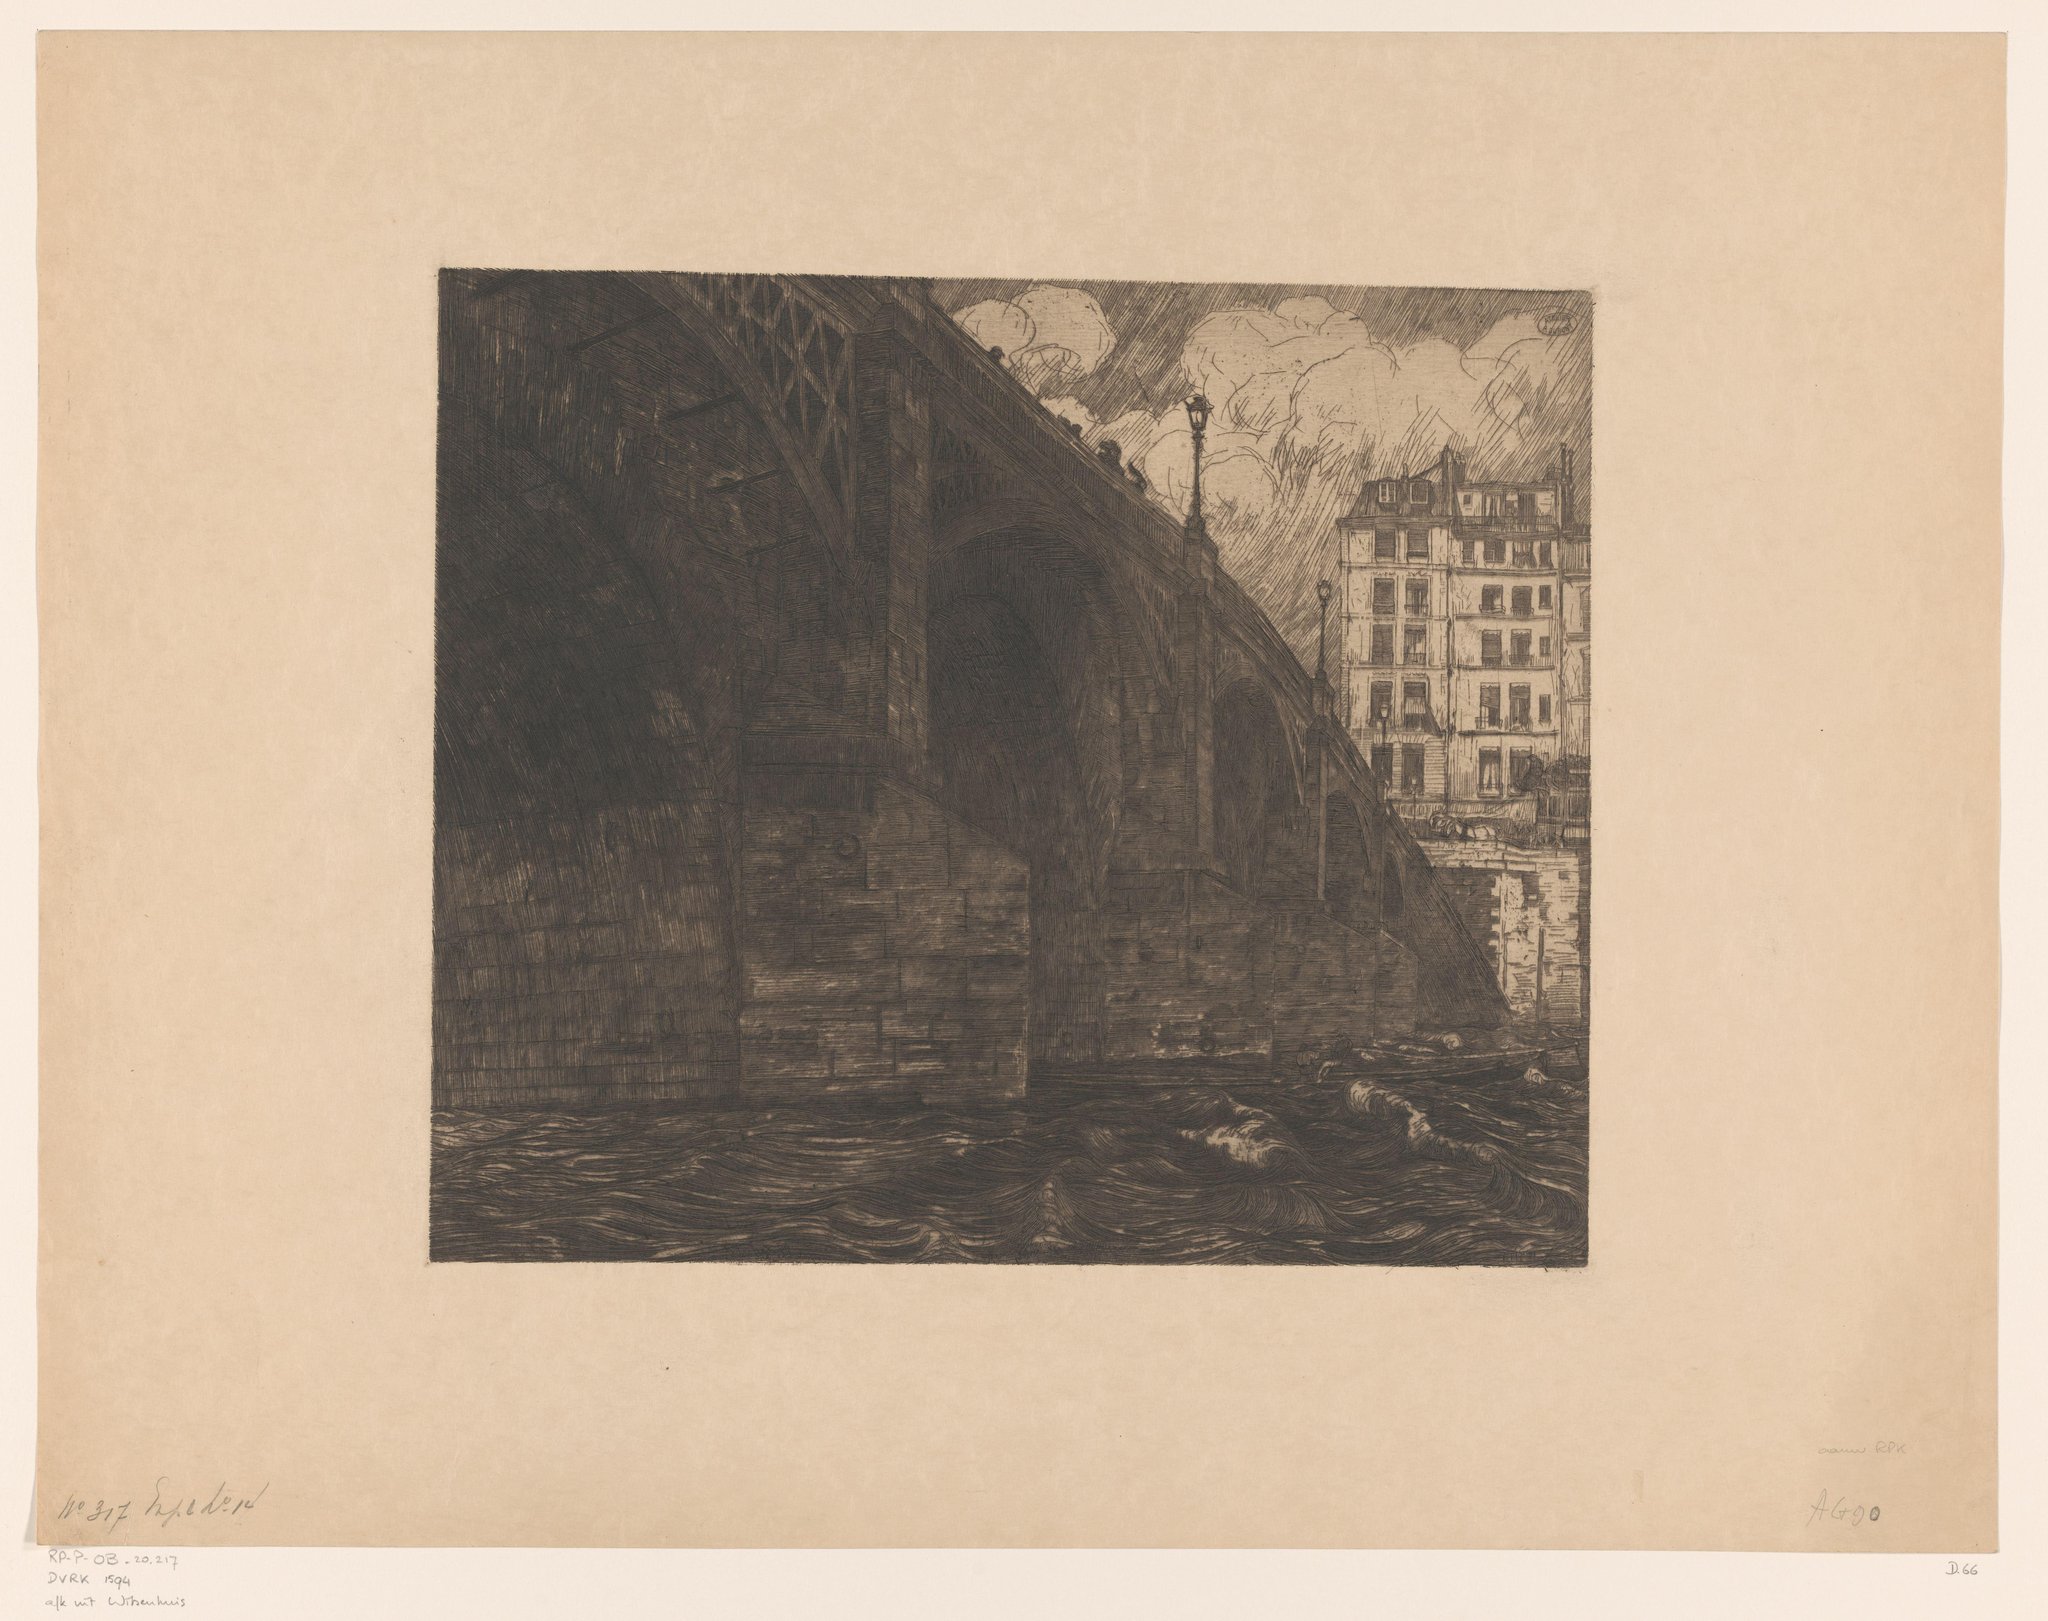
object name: print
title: Pont de la Tournelle in Parijs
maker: pieter dupont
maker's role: draughtsman, print maker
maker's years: 1870-1911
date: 1898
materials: paper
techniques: etching, intaglio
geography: amsterdam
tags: bridge in city across river, canal, etc.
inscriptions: inscription: ‘No. 317 [...] No. 14’, collector's mark: Lugt 705a